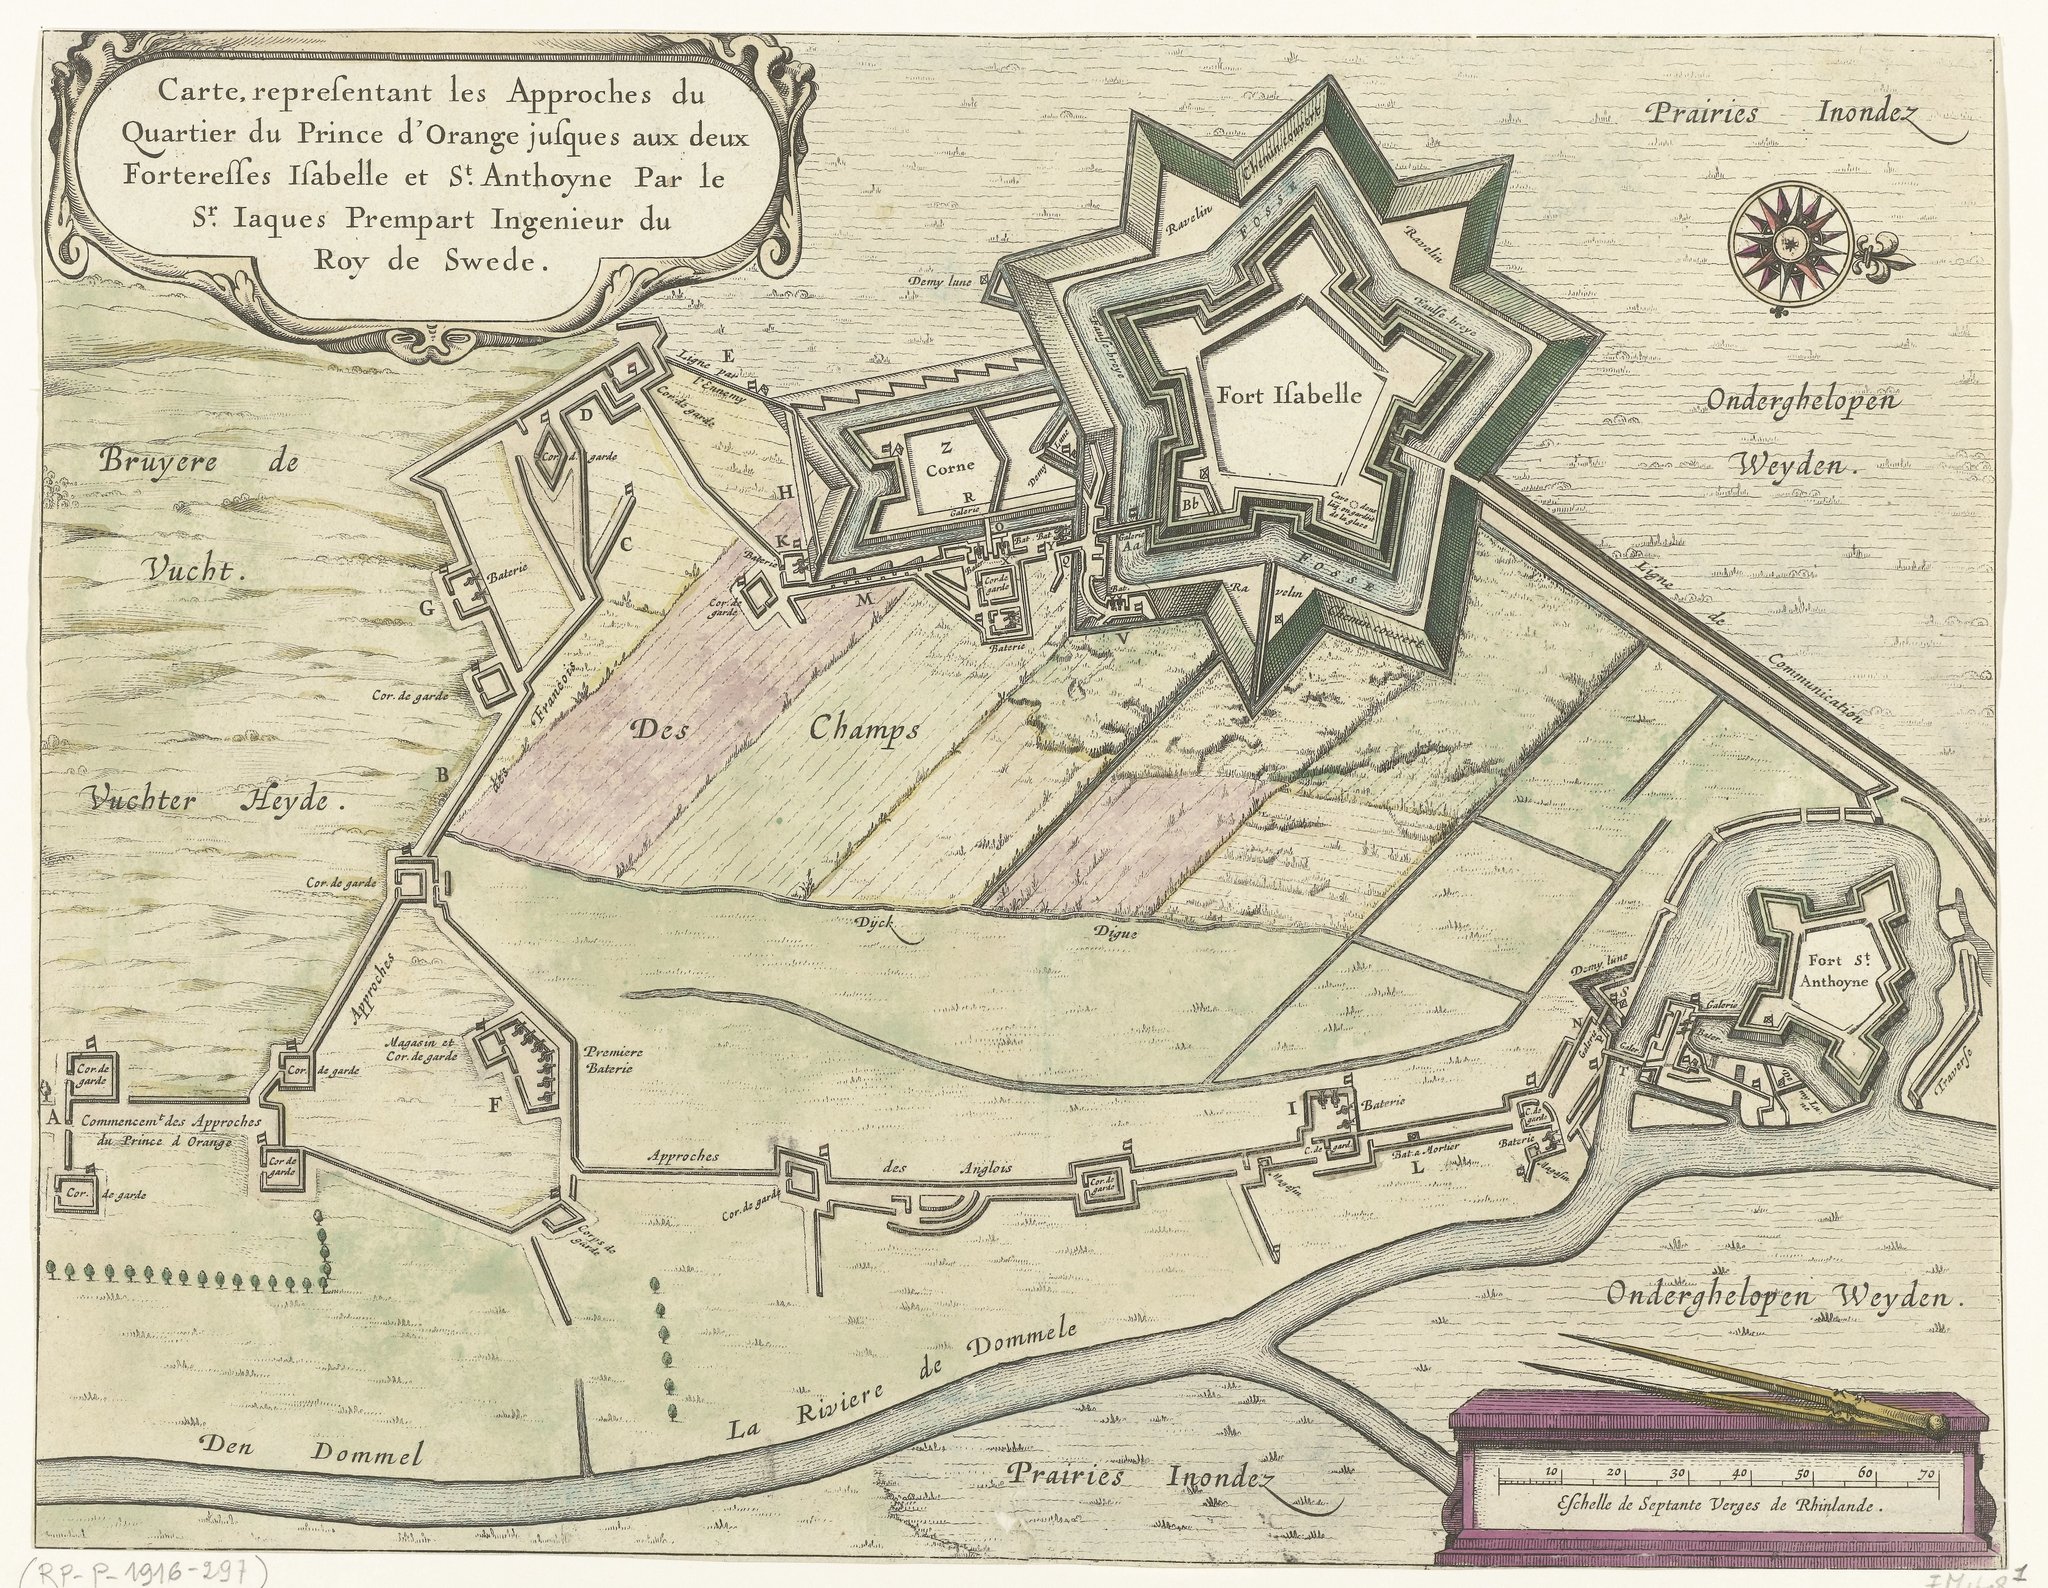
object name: print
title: Carte, representant les Approches du Quartier du Prince d'Orange jusques aux deux Forteresses Isabelle et St. Anthoyne Par le Sr. Jaques Prempart Ingenieur du Roy de Swede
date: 1629-1630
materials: paper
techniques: etching, hand coloring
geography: northern netherlands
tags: the hague, frederick henry (prince of orange), maps of separate countries or regions, fortifications, military engineering, den bosch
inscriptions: collector's mark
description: Plattegrond met de loopgraven van het Staatse leger bij de forten Isabella en Sint-Anthonie. Onderdeel van het beleg van Den Bosch door het Staatse leger onder Frederik Hendrik, van 1 mei tot 17 september 1629. Opschriften in de voorstelling in het Frans en Nederlands. Behoort waarschijnlijk bij de grote kaart van het beleg.